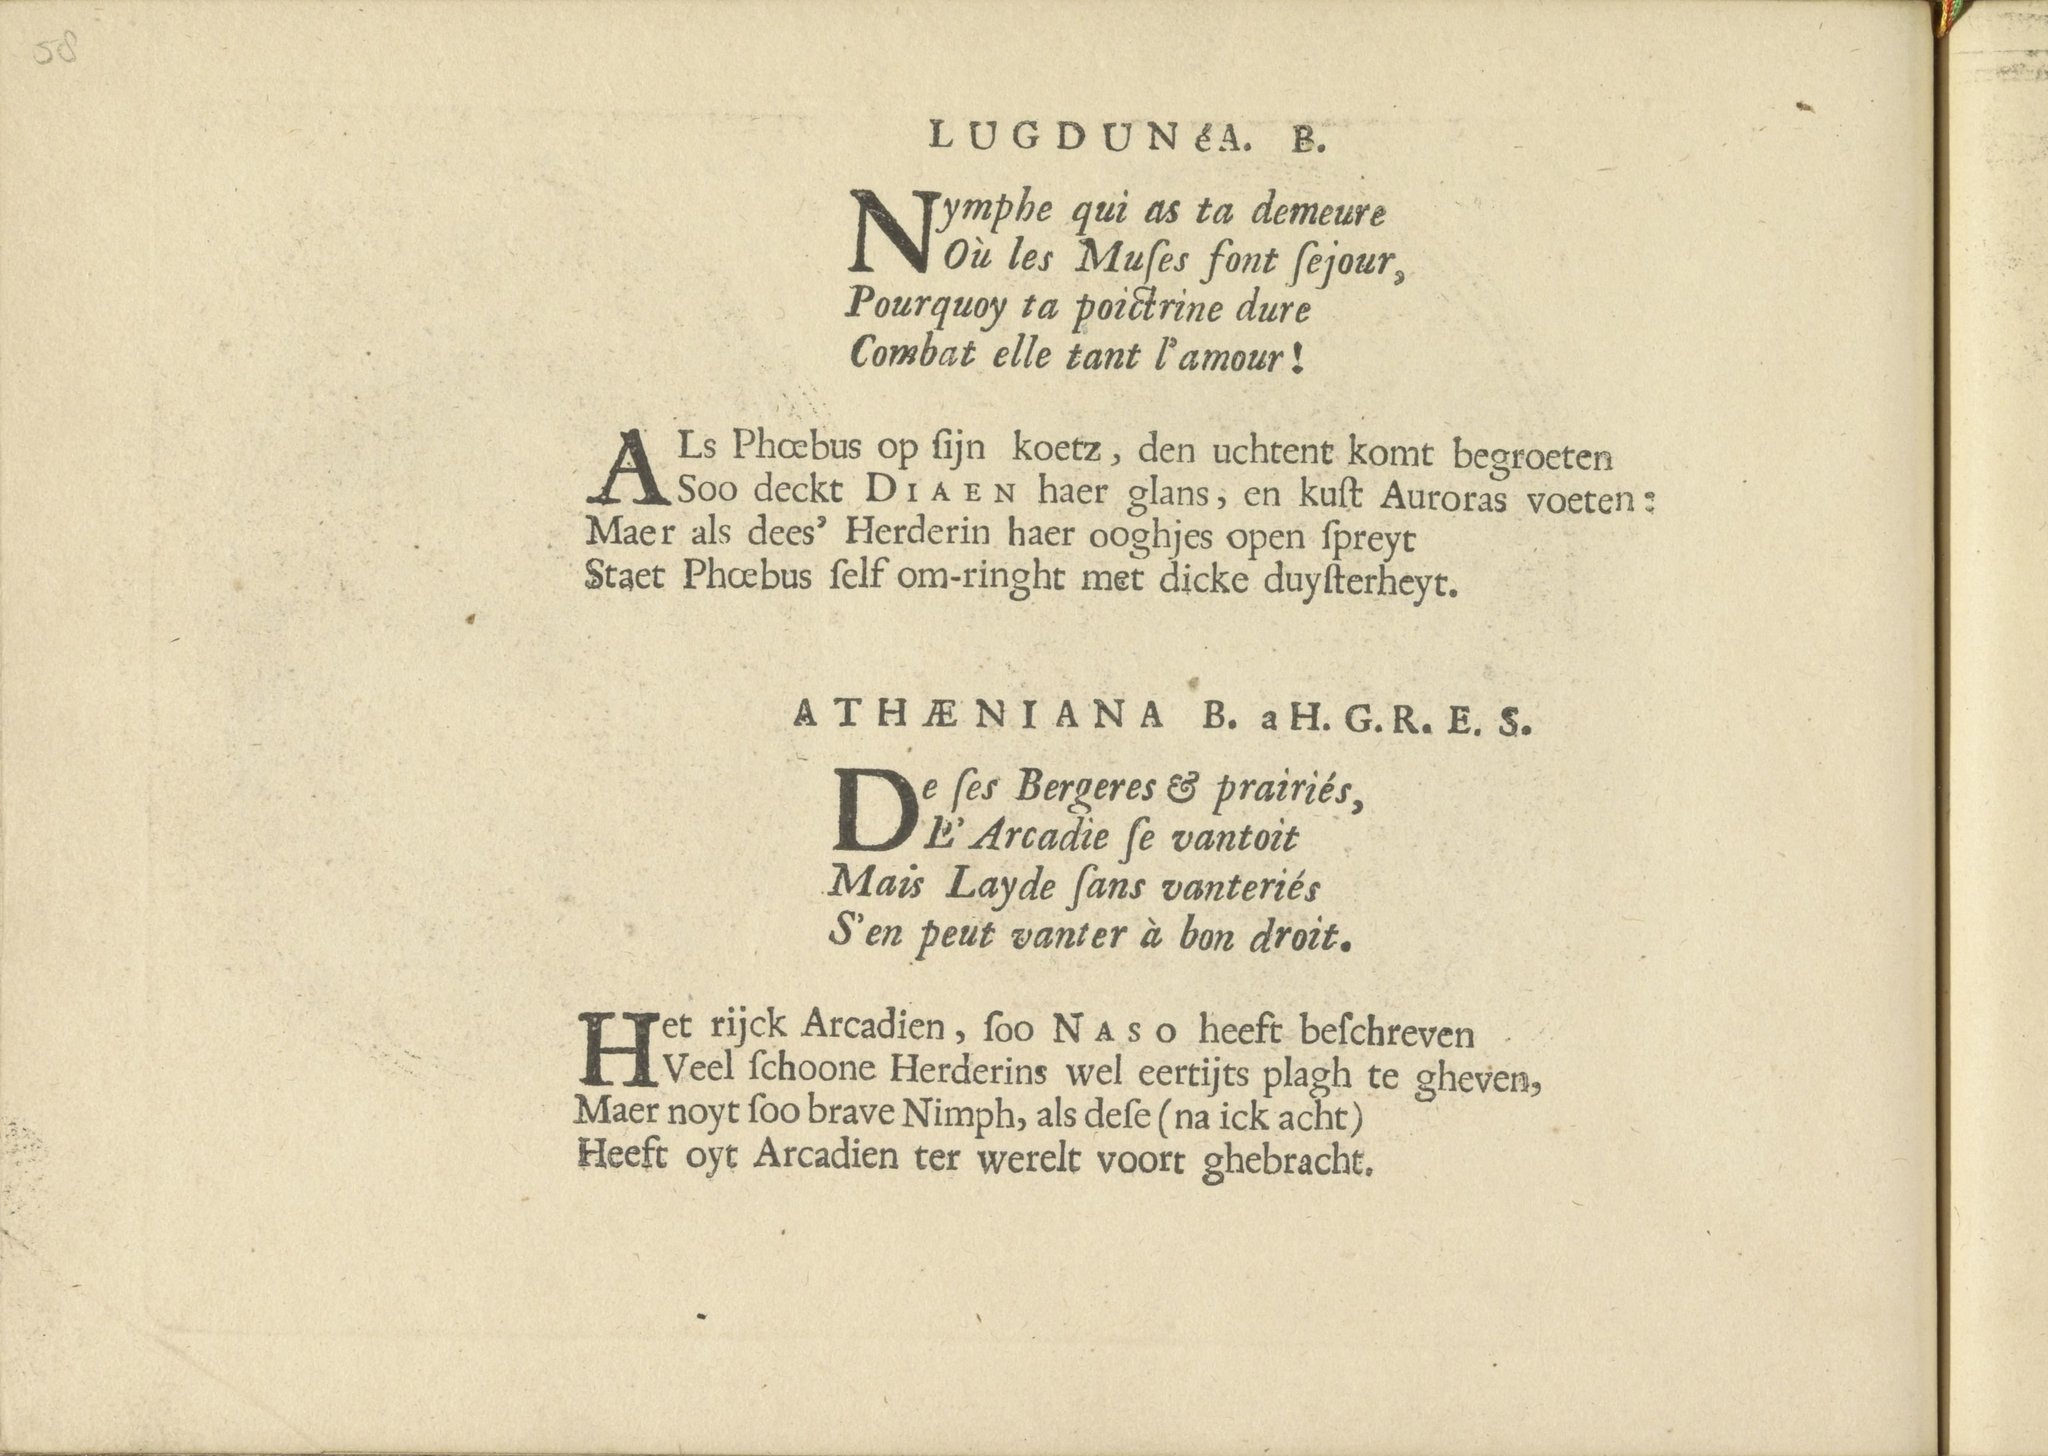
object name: text sheet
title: Kwatrijnen bij de voorstellingen van Lugdunea B. en Athaeniana B.aH.G.R.E.S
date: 1640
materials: paper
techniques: letterpress printing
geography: amsterdam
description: Twee keer twee kwatrijnen in het Frans en Nederlands bij de voorstellingen van Lugdunea B. en Athaeniana B.aH.G.R.E.S. Het blad maakt deel uit van een album.